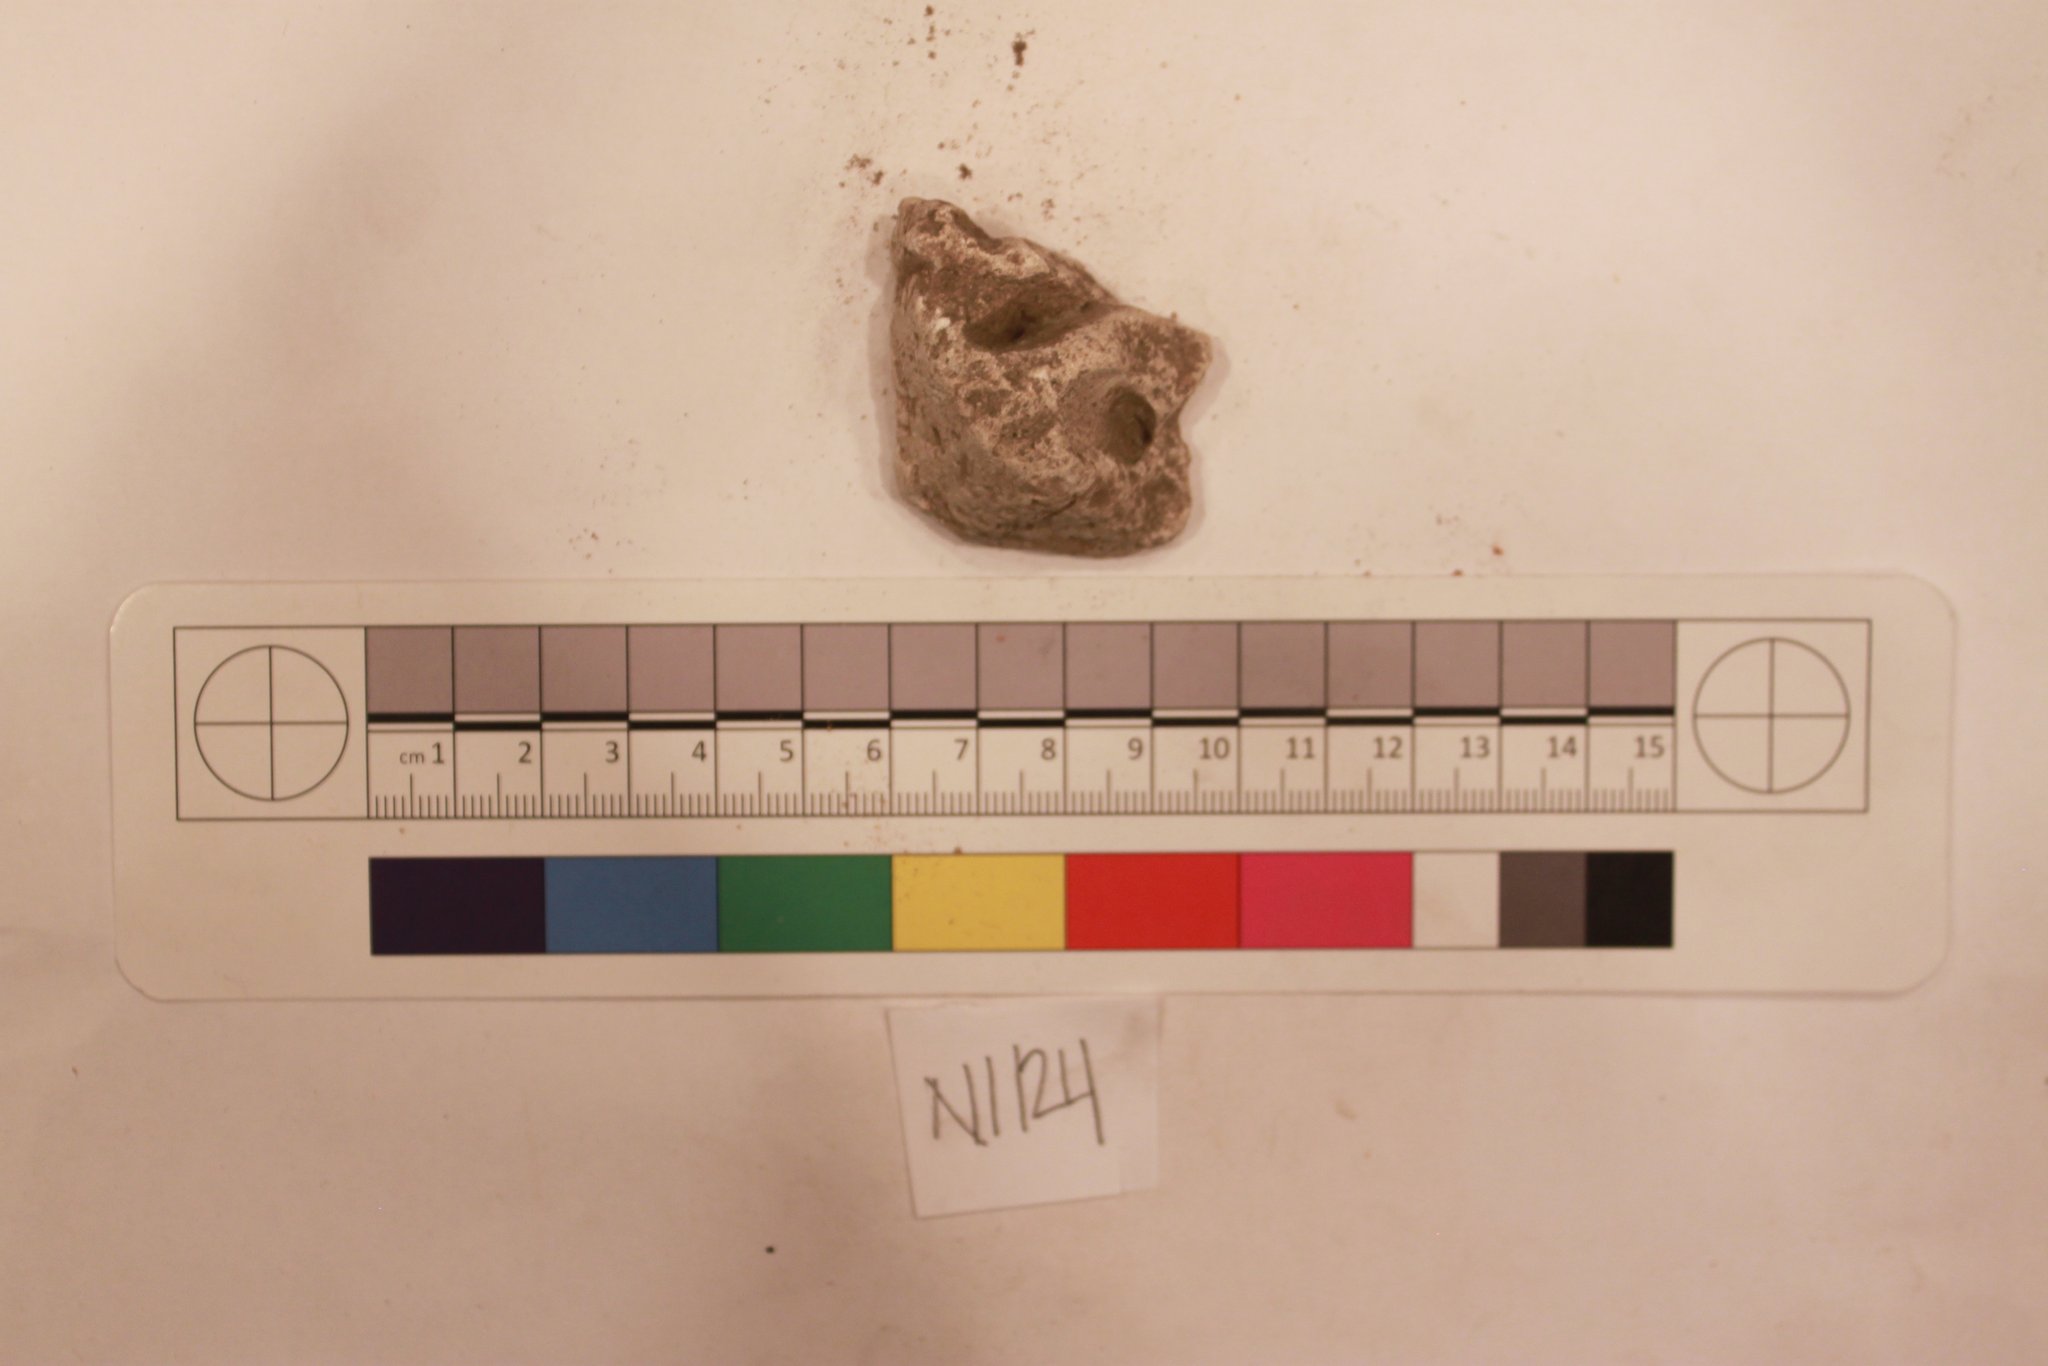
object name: fragment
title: Stucco Fragment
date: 701-1200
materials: plaster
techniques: carving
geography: iran